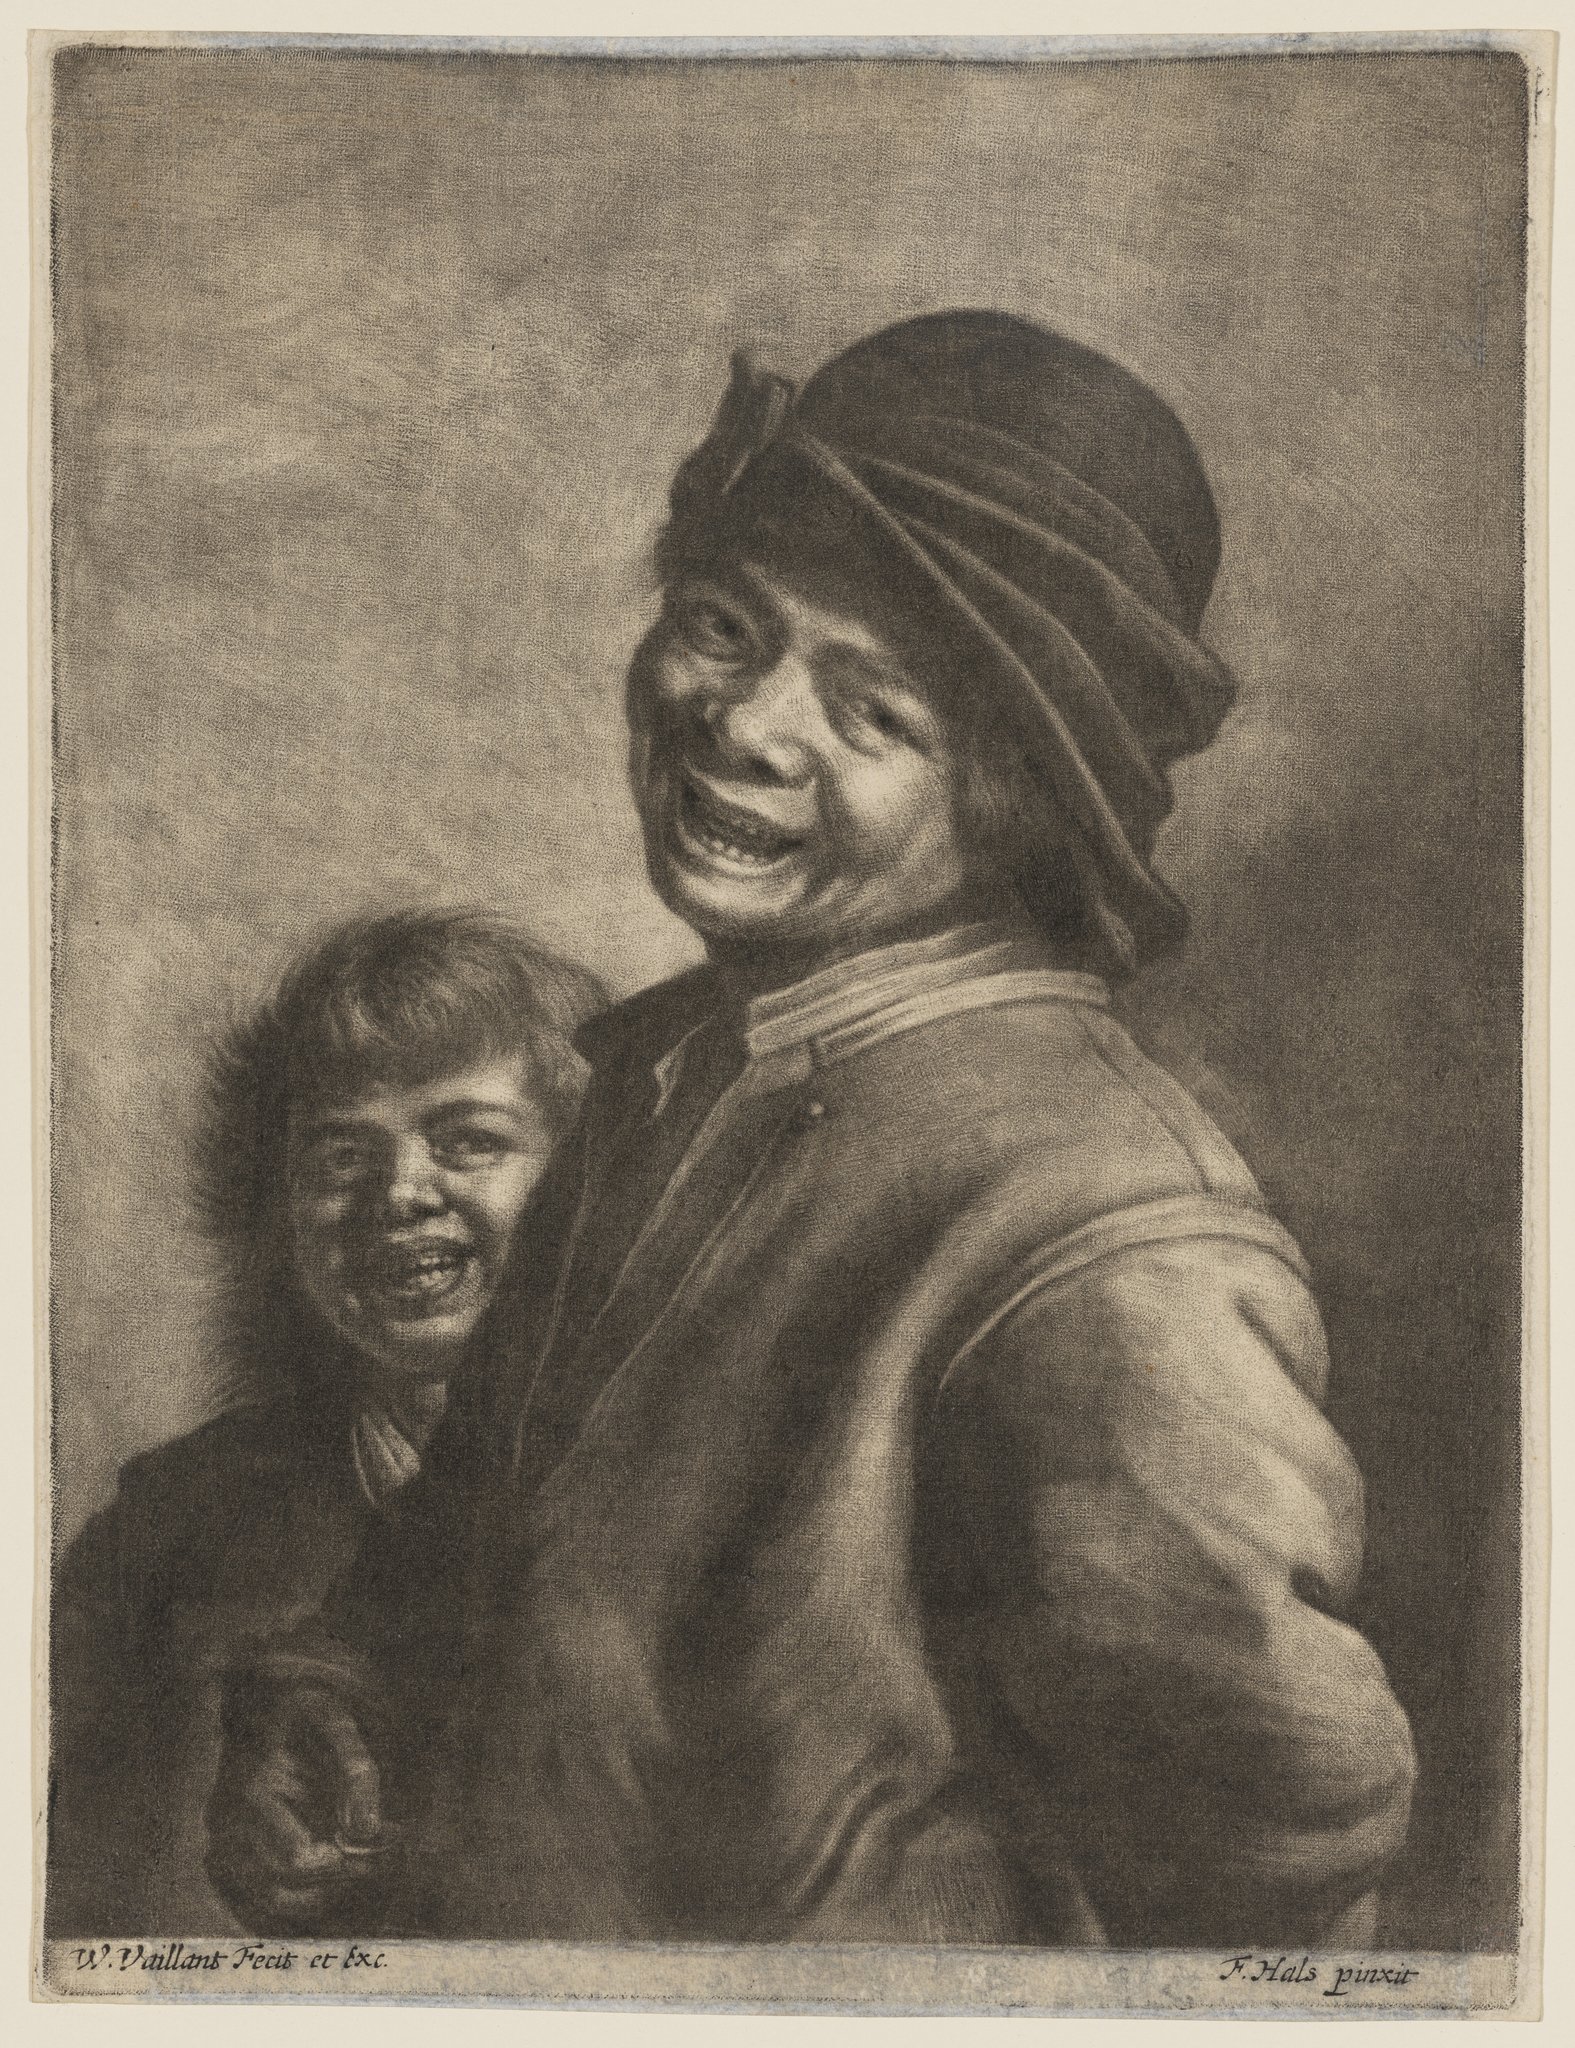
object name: print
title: Two Boys Laughing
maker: wallerant vaillant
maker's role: artist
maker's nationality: dutch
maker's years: 1623-1677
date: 1634-1666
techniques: mezzotint